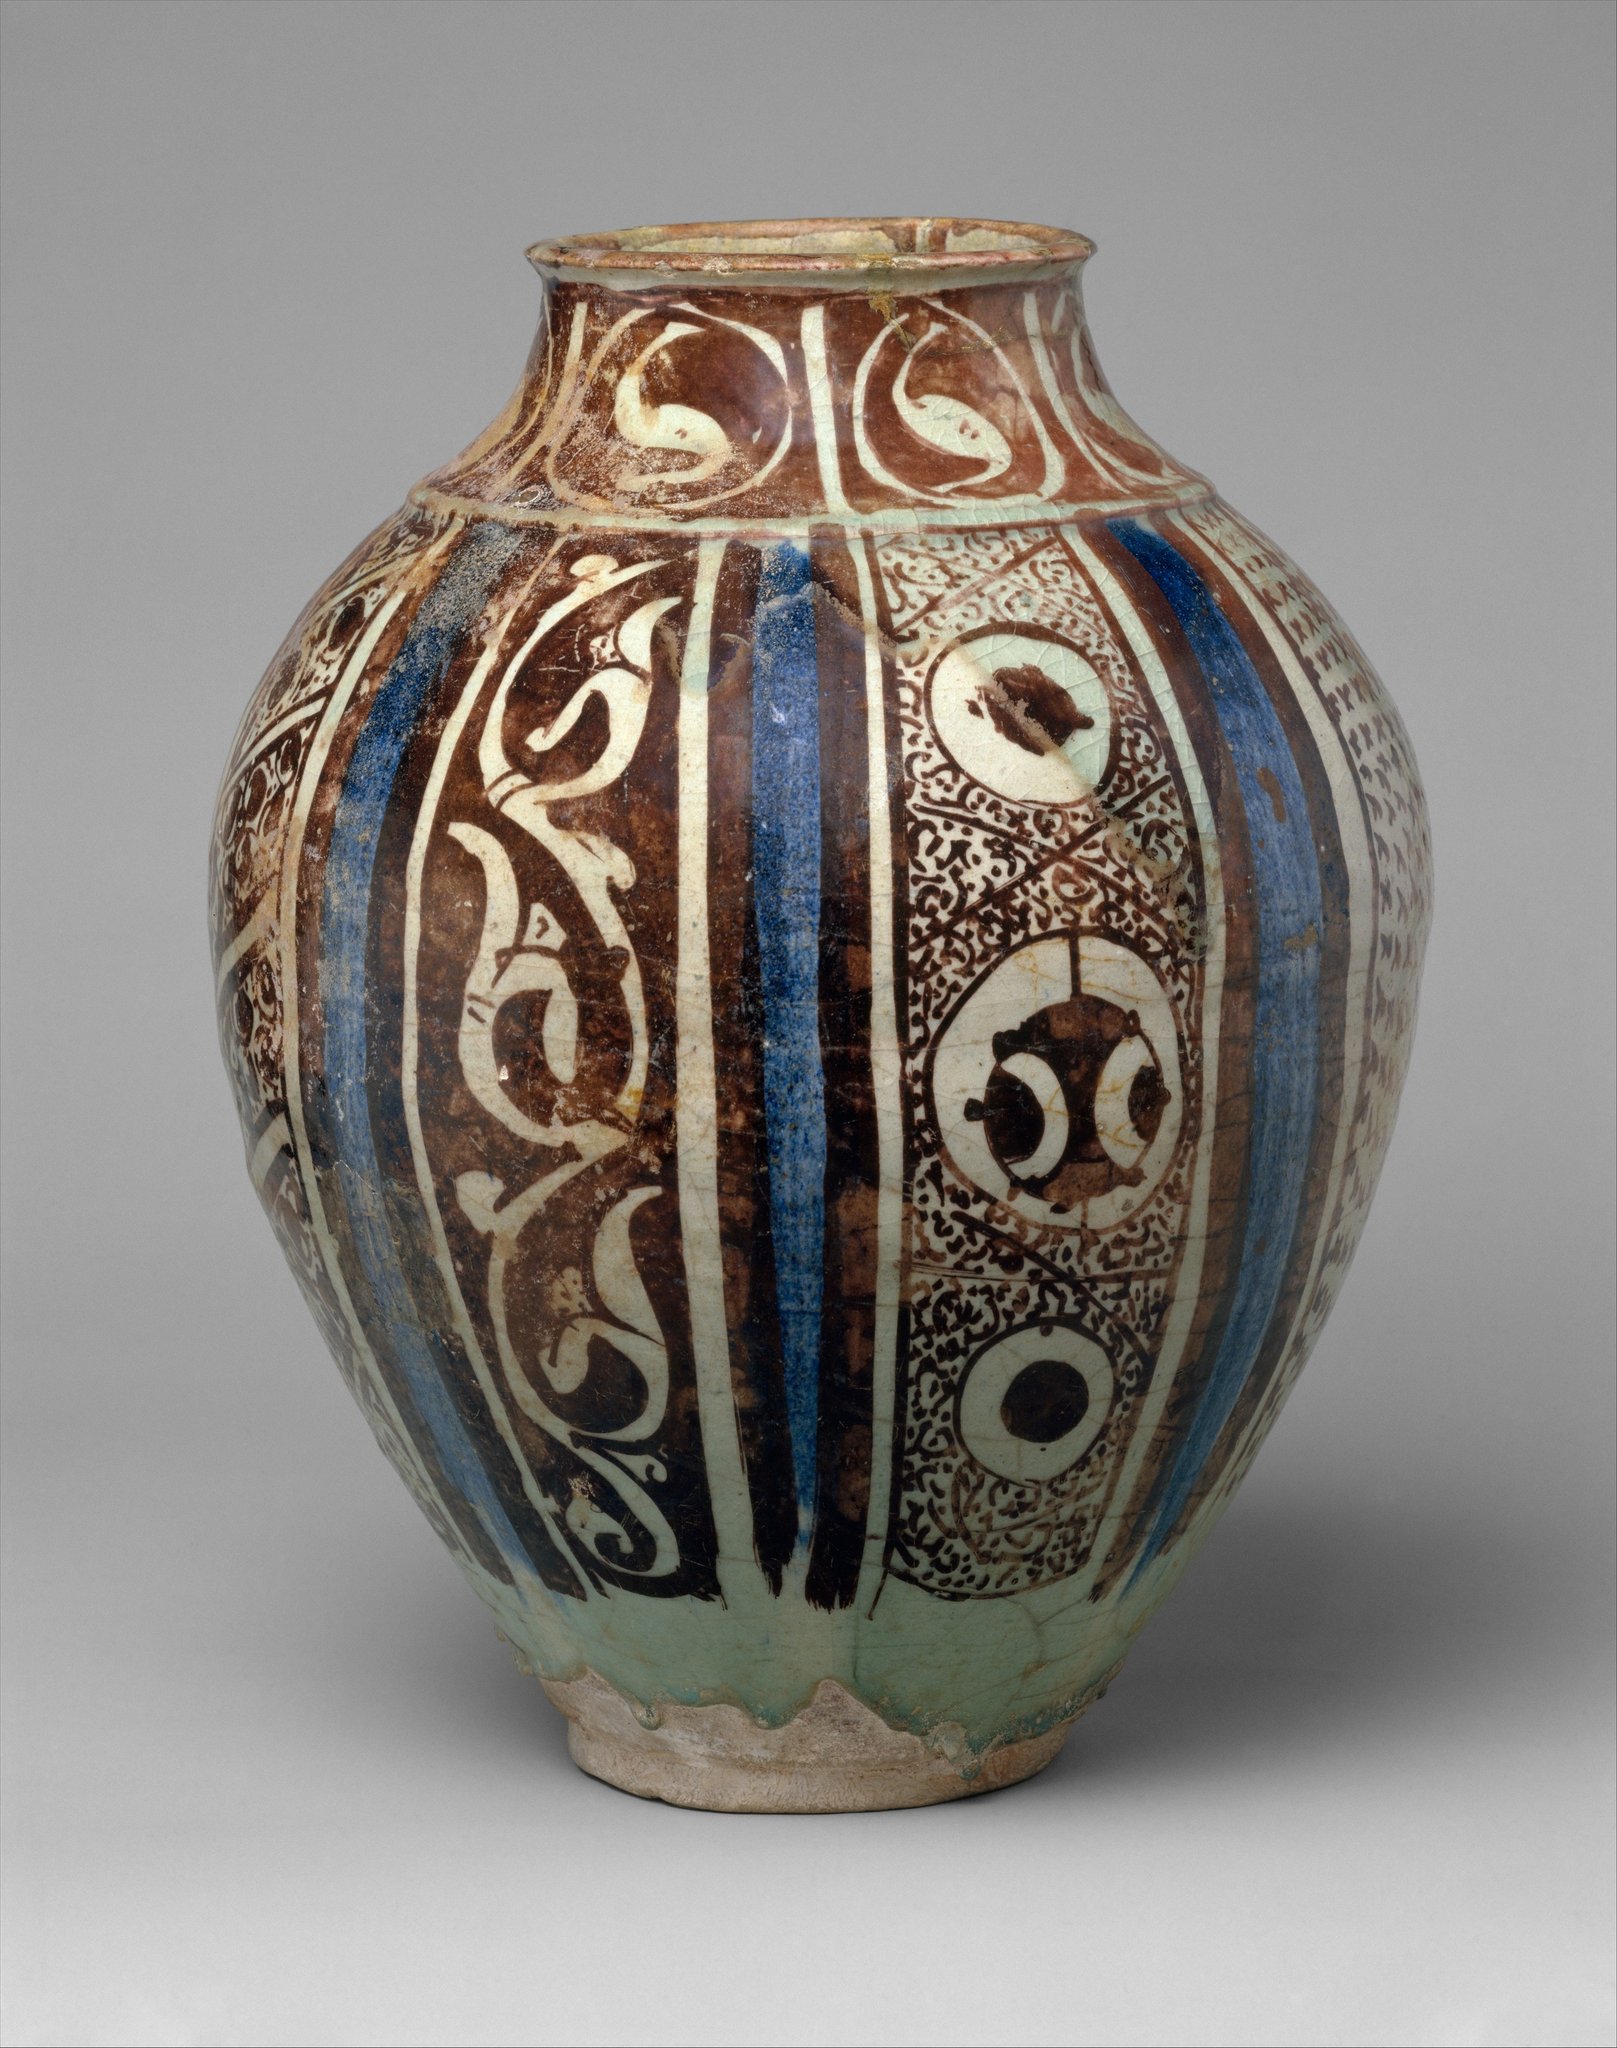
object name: jar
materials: glaze, stonepaste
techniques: painting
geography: syria